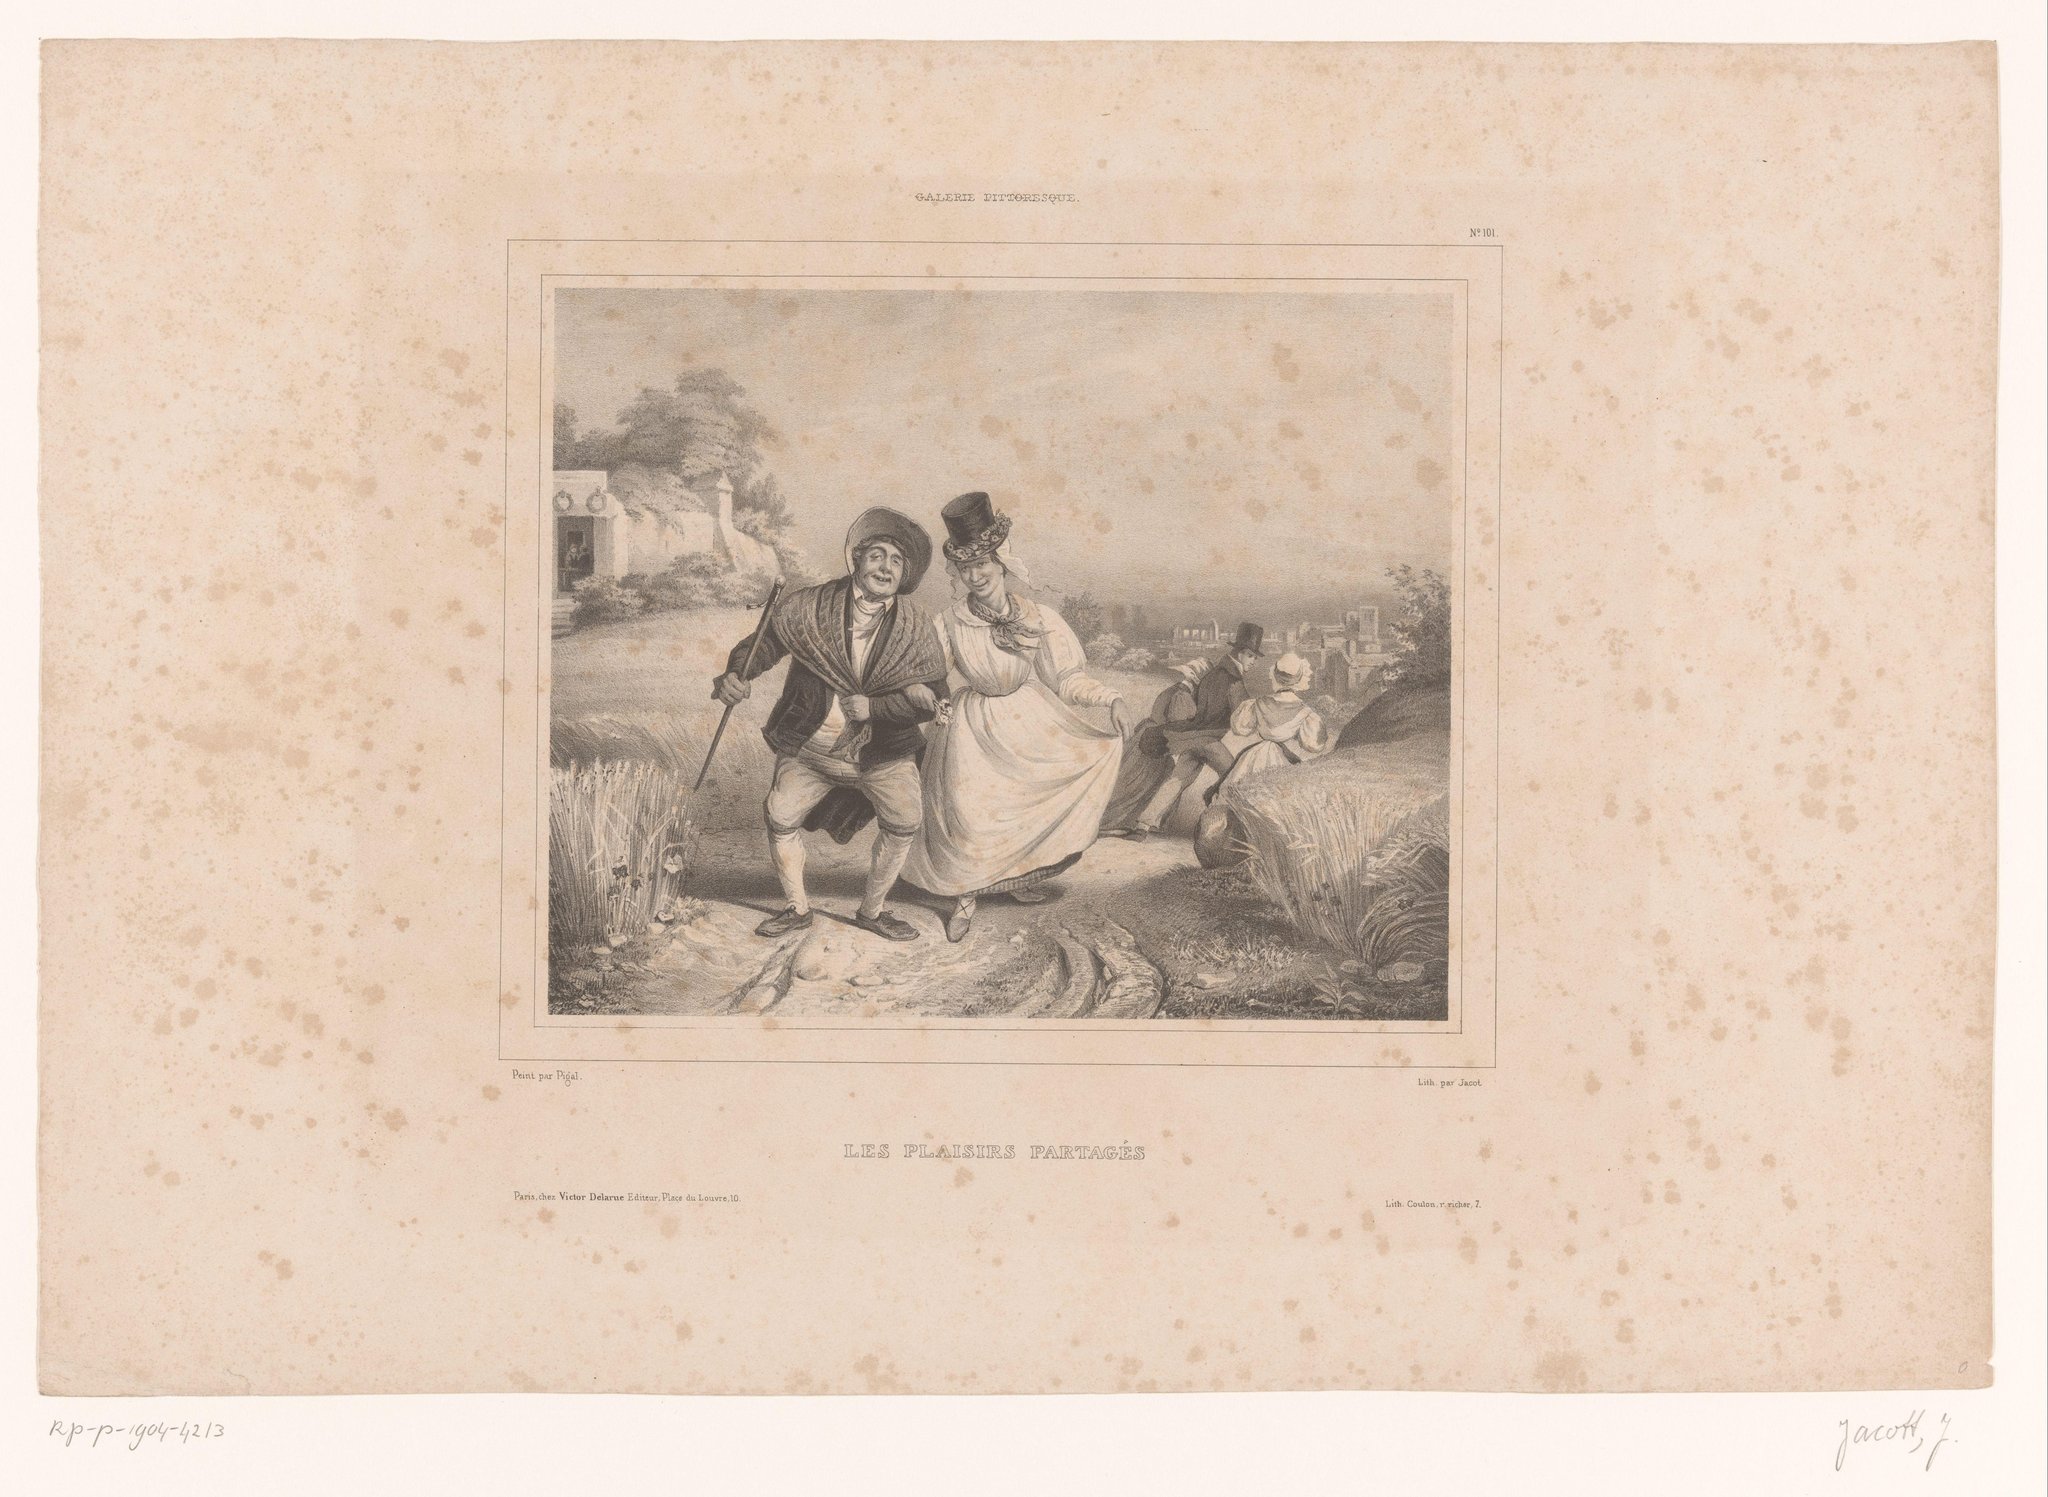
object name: print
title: Galerie pittoresque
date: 1837-1849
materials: paper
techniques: lithograph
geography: paris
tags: walking, hiking (recreation), arm in arm (lovers)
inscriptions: collector's mark: Lugt 2228a